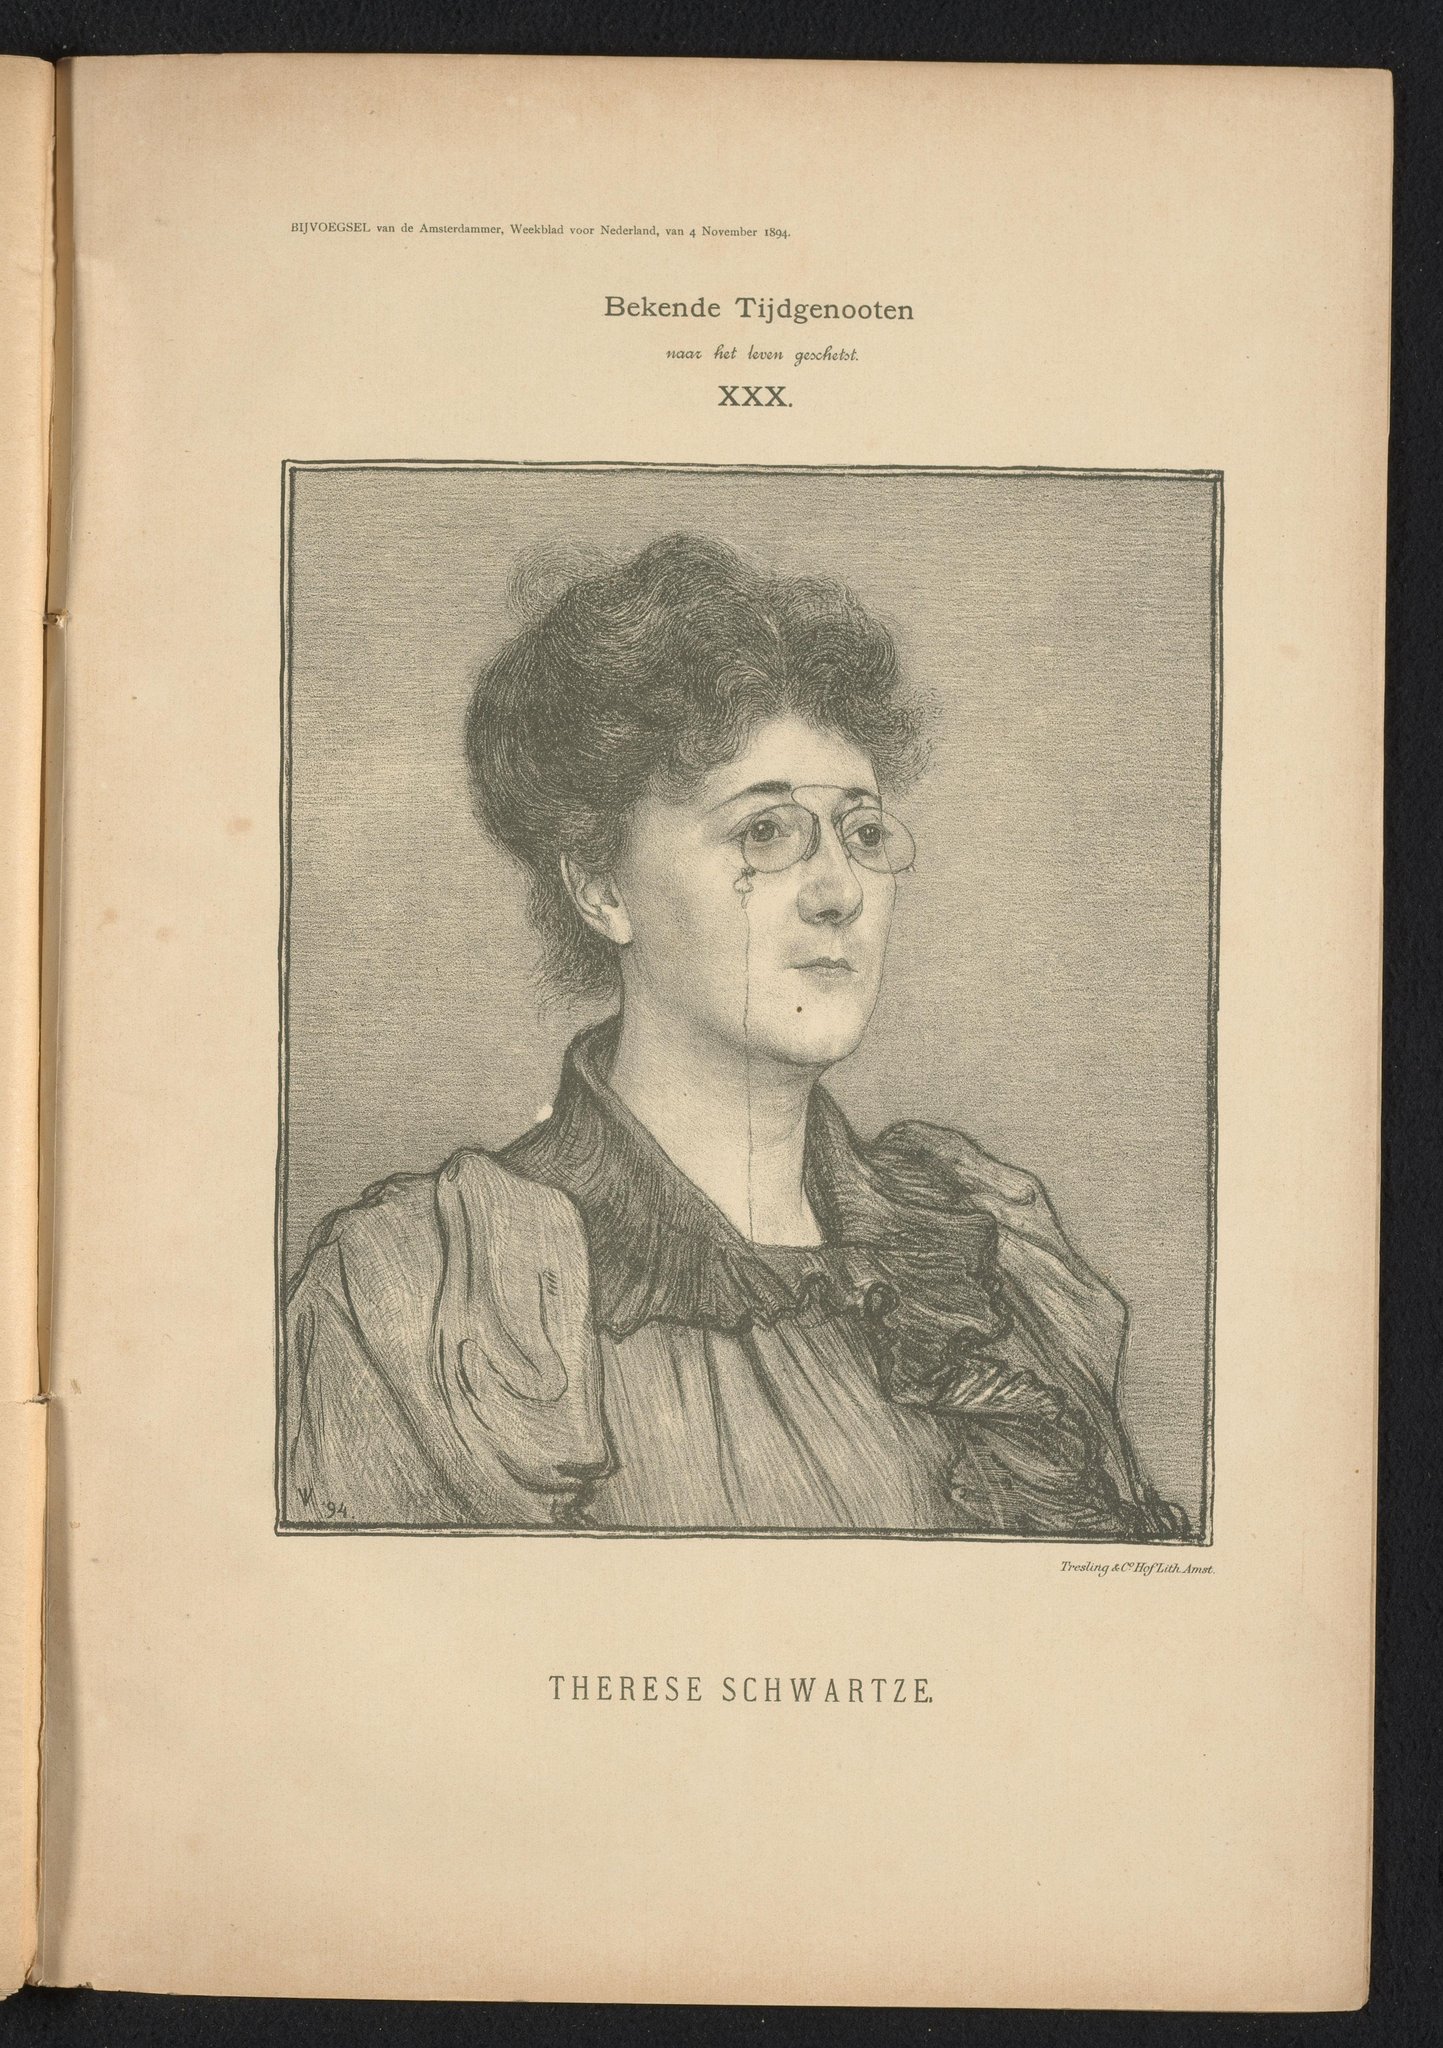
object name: print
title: Bekende Tijdgenooten naar het leven geschetst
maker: jan veth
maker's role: designer, draughtsman, painter, print maker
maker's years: 1864-1925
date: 1894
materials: paper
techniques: lithograph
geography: netherlands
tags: amsterdam, painter, print maker, thérèse schwartze, historical persons - bb - woman (+ (full) bust portrait), portrait, self-portrait of painter, portrait, self-portrait of artist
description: Portret van de kunstenares Thérèse Schwartze. In de serie 'Bekende Tijdgenooten', nr. XXX.